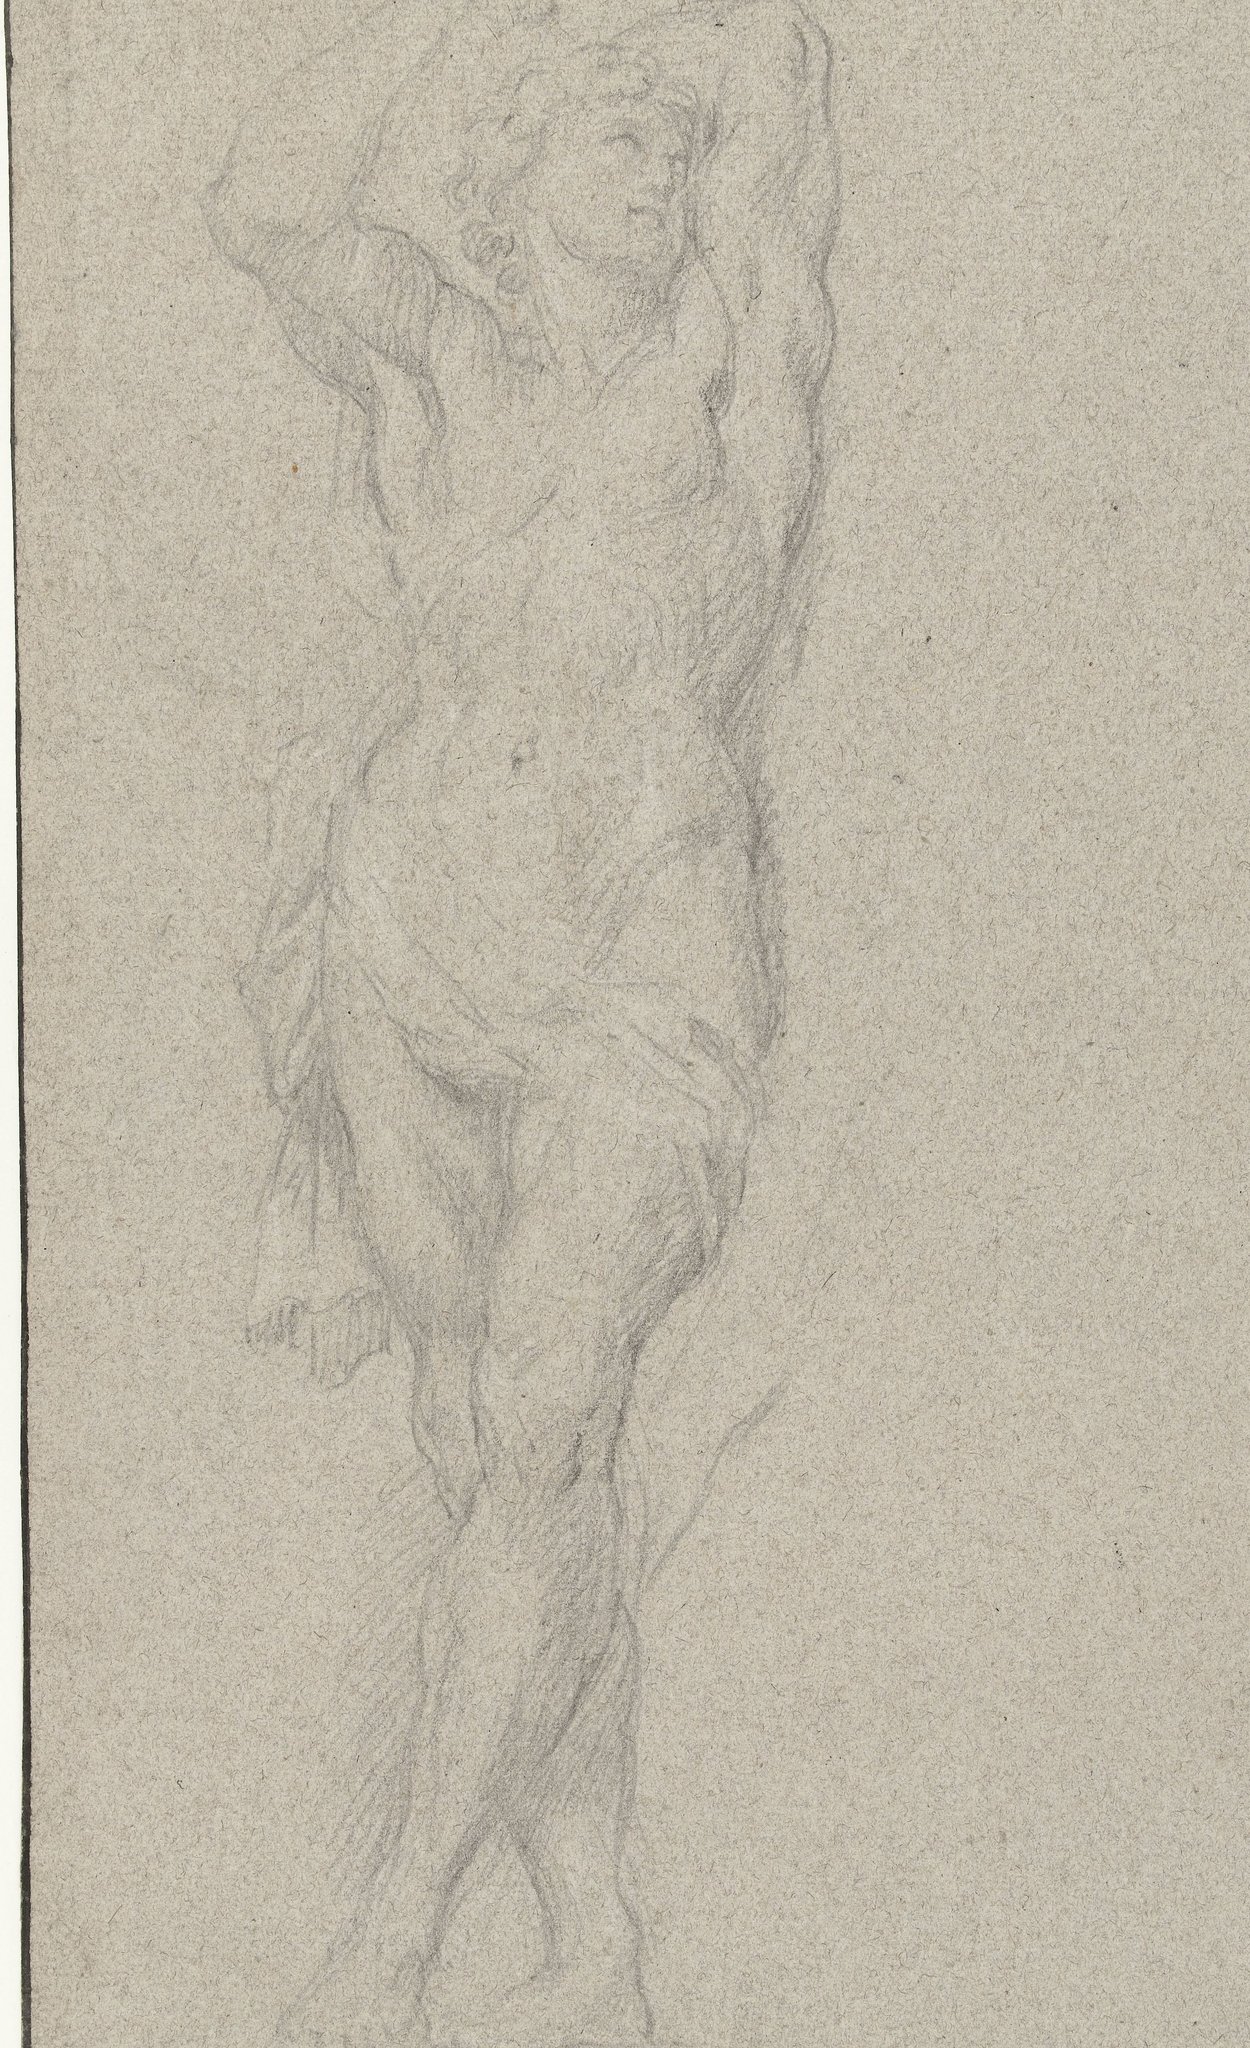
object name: drawing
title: Studie voor een Atlant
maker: giuseppe maria mitelli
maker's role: draughtsman, painter, print maker, publisher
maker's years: 1634-1718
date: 1644-1718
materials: chalk, paper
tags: atlantes ~ architecture